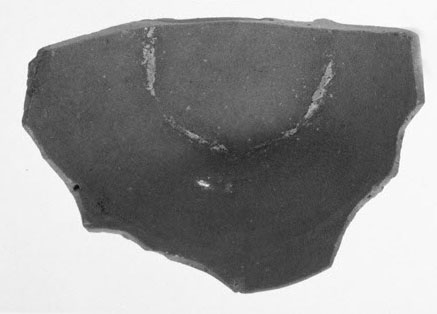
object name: fragment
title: Fragment of a Bowl (Study Collection)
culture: chinese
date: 960-1279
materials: ceramic glaze, ceramic, glaze